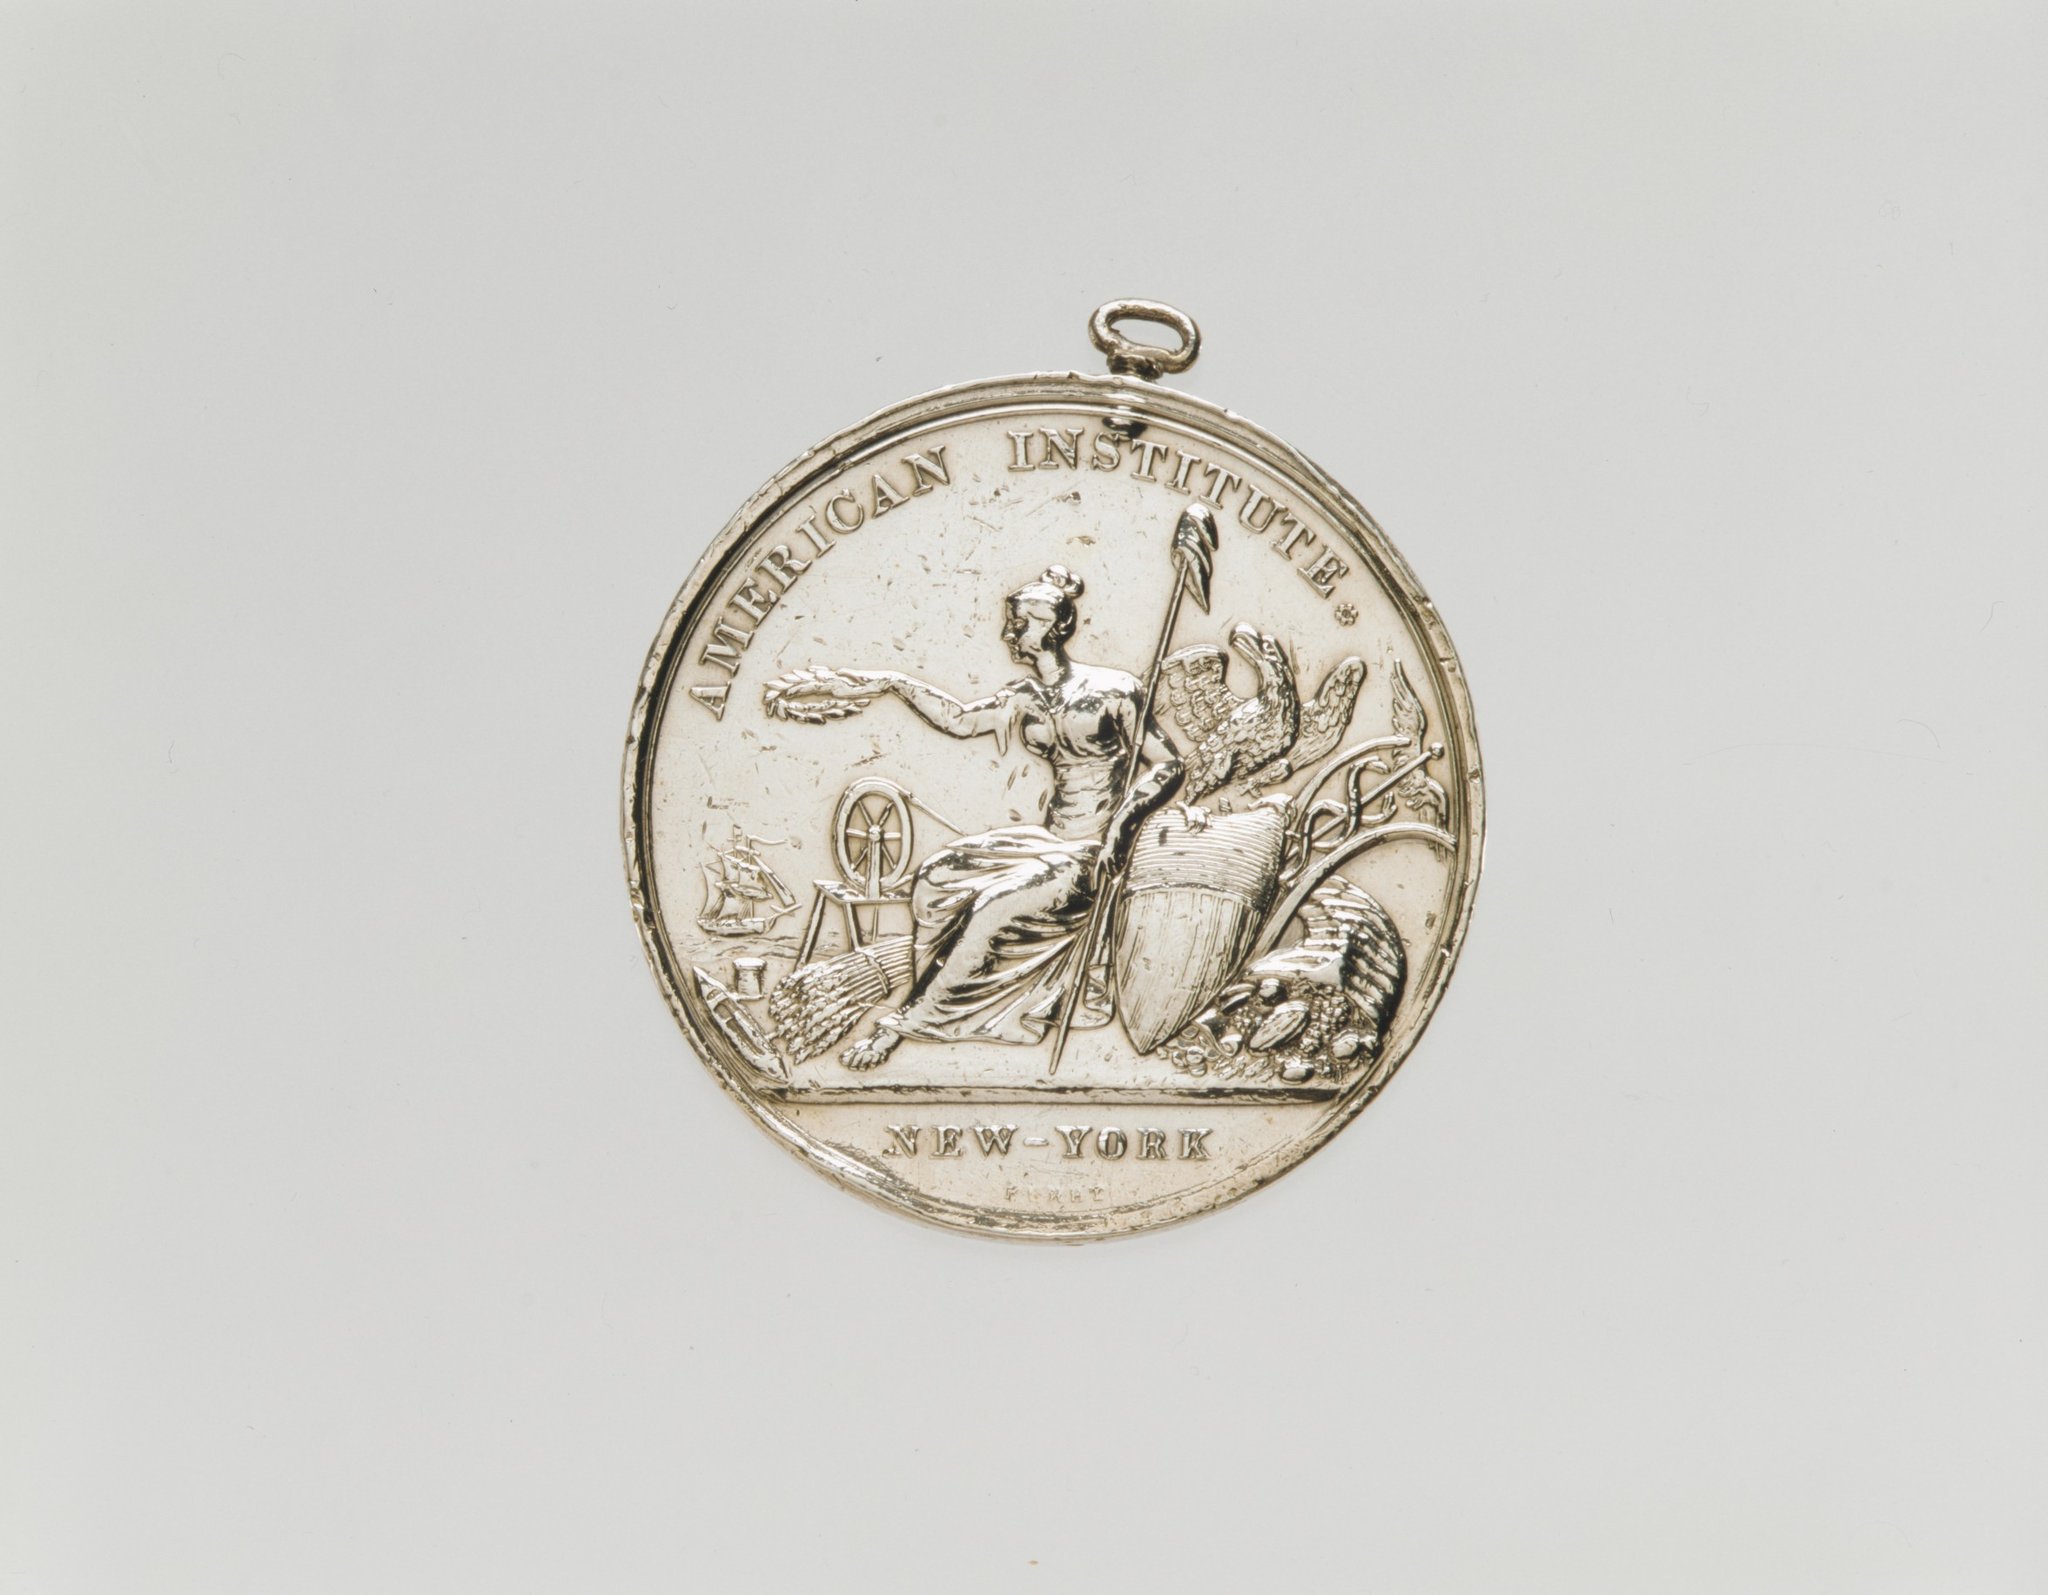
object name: medal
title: American Institute Award Medal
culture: american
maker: moritz fürst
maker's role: artist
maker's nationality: hungarian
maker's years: 1782-1882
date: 1838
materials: silver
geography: united states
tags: eagles,women